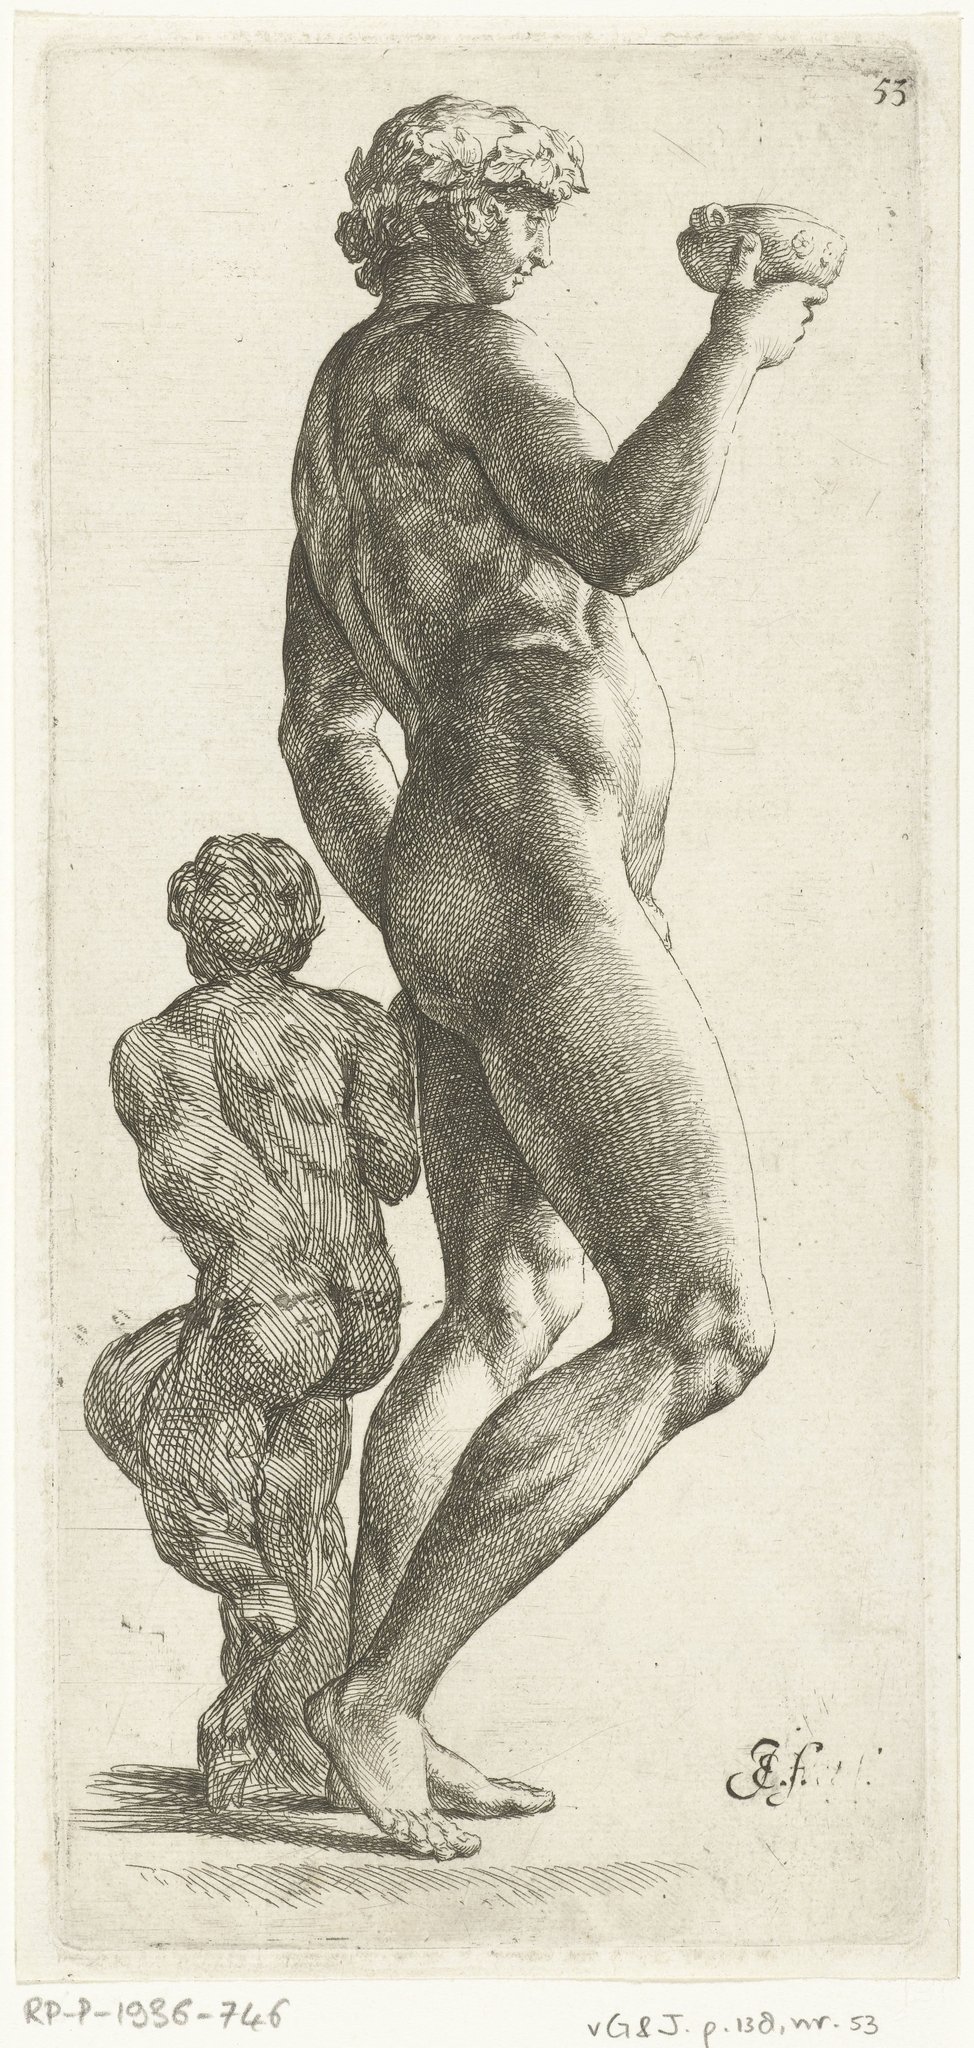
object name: print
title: Bacchus met een jonge sater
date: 1664-1669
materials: paper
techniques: etching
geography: northern netherlands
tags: (story of) bacchus (dionysus), liber, satyr(s) (in general)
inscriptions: collector's mark: Lugt 2228, collector's mark: Lugt 2760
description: afkomstig uit: Jan de Bisschop, Signorum Veterum Icones, deel 2, [c. 1669]